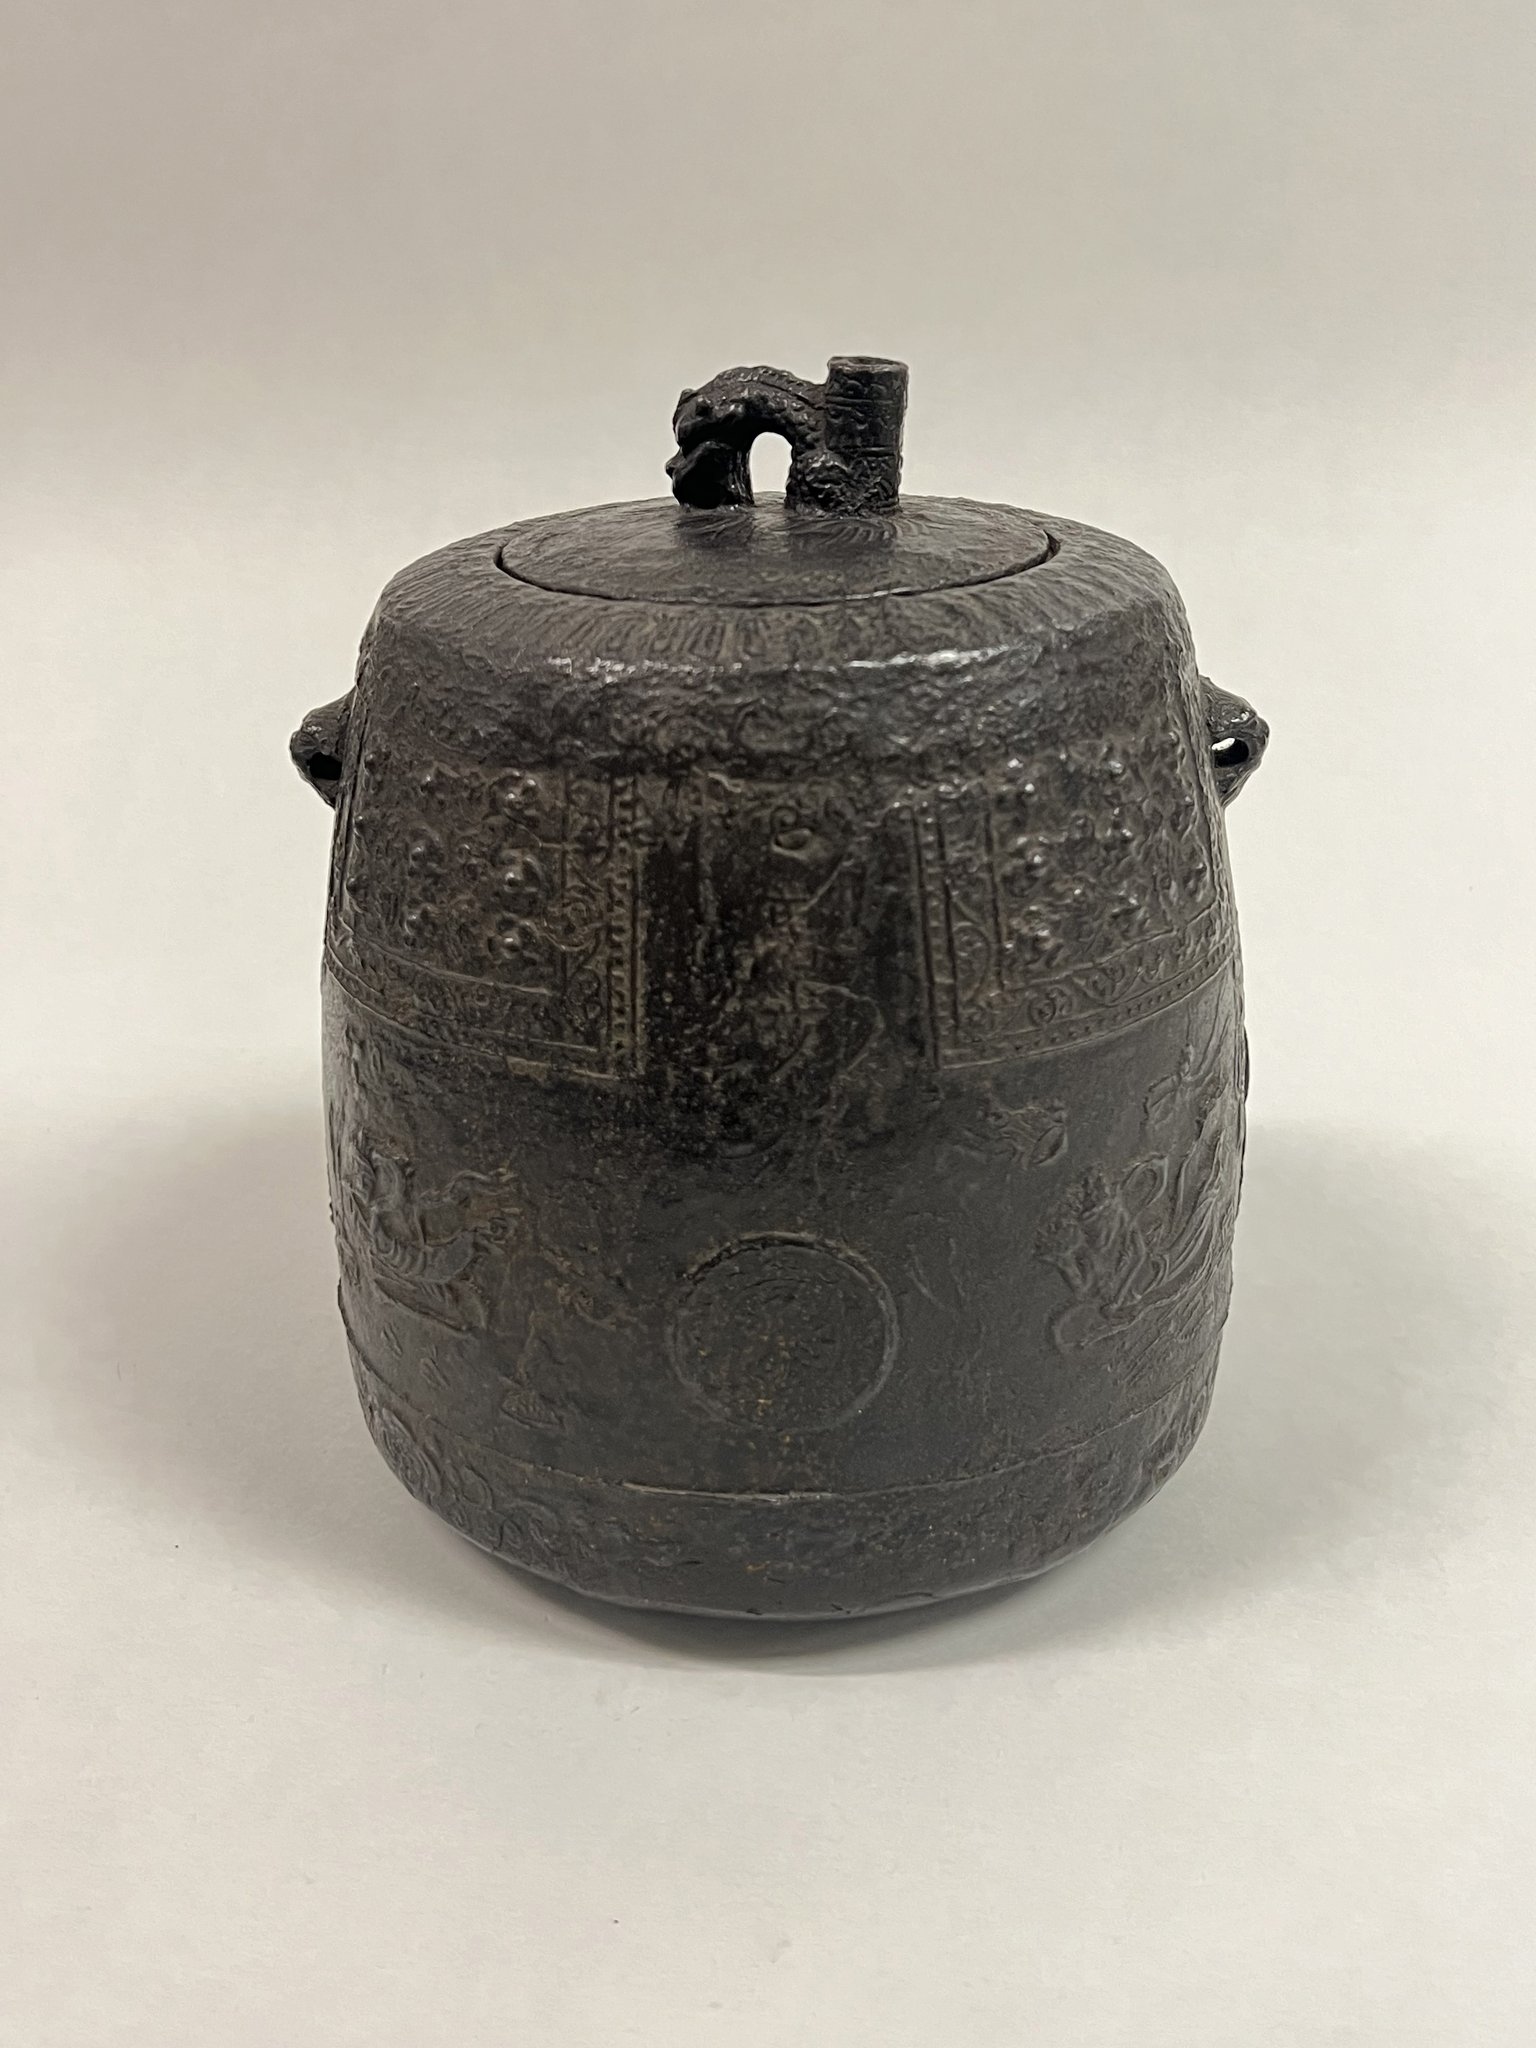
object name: jar with cover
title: Water Jar with Cover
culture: japanese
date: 1701-1800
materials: iron